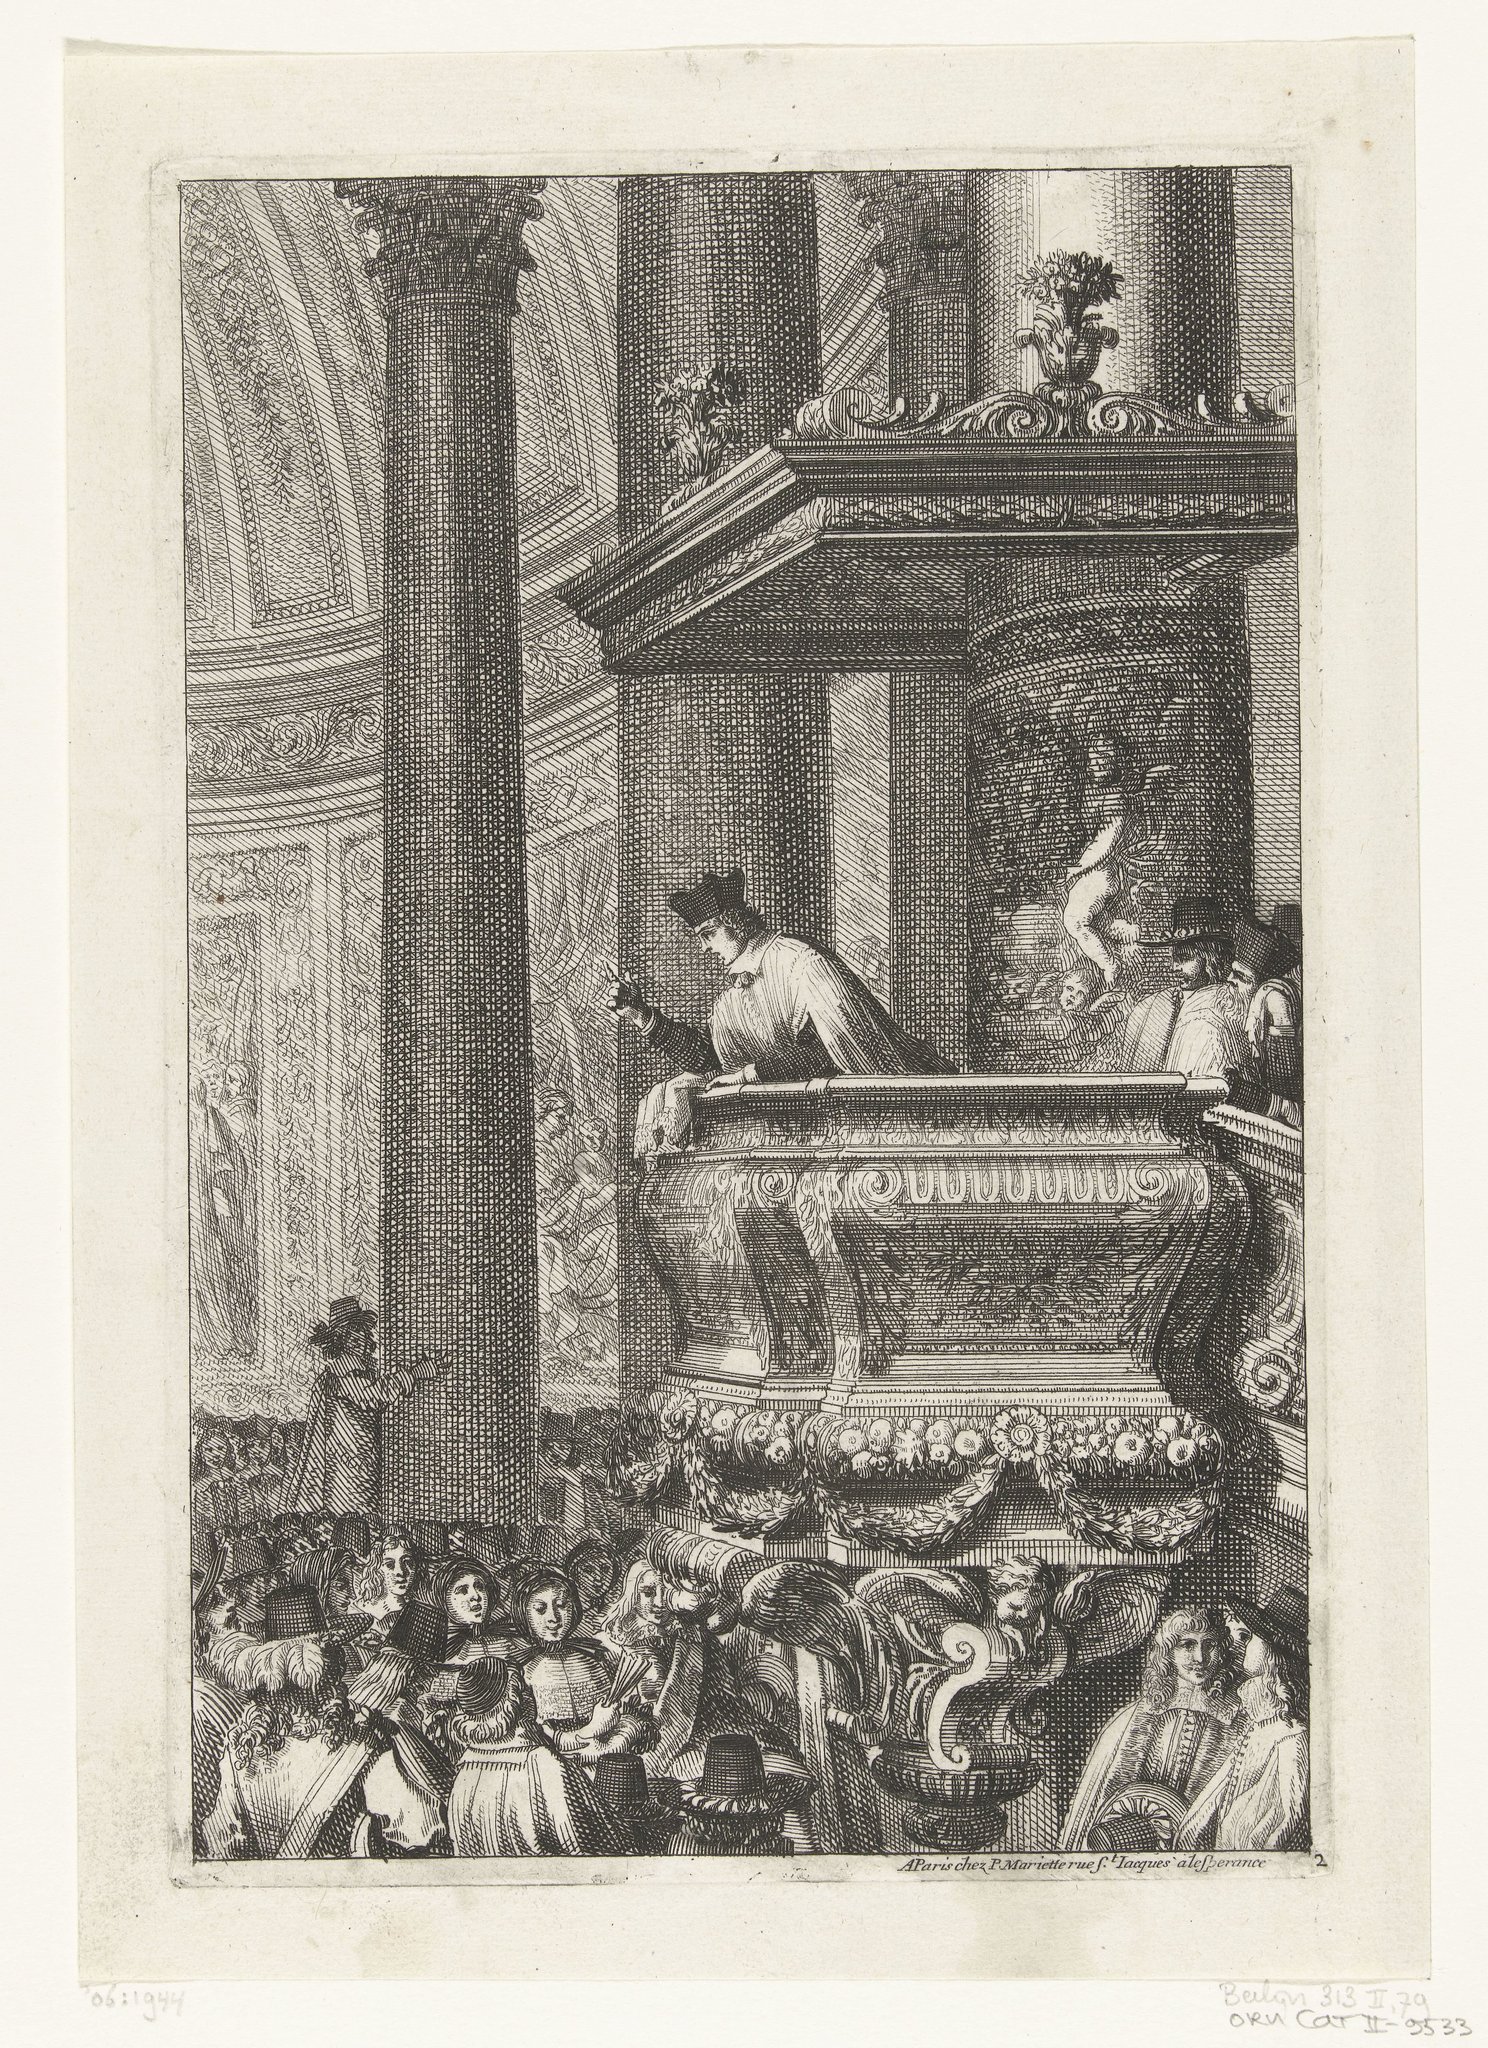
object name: ornament print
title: Chaires de Predicateurs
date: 1659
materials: paper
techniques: etching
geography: paris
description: Met een hangend vierkant lichaam. Uit tweede editie.